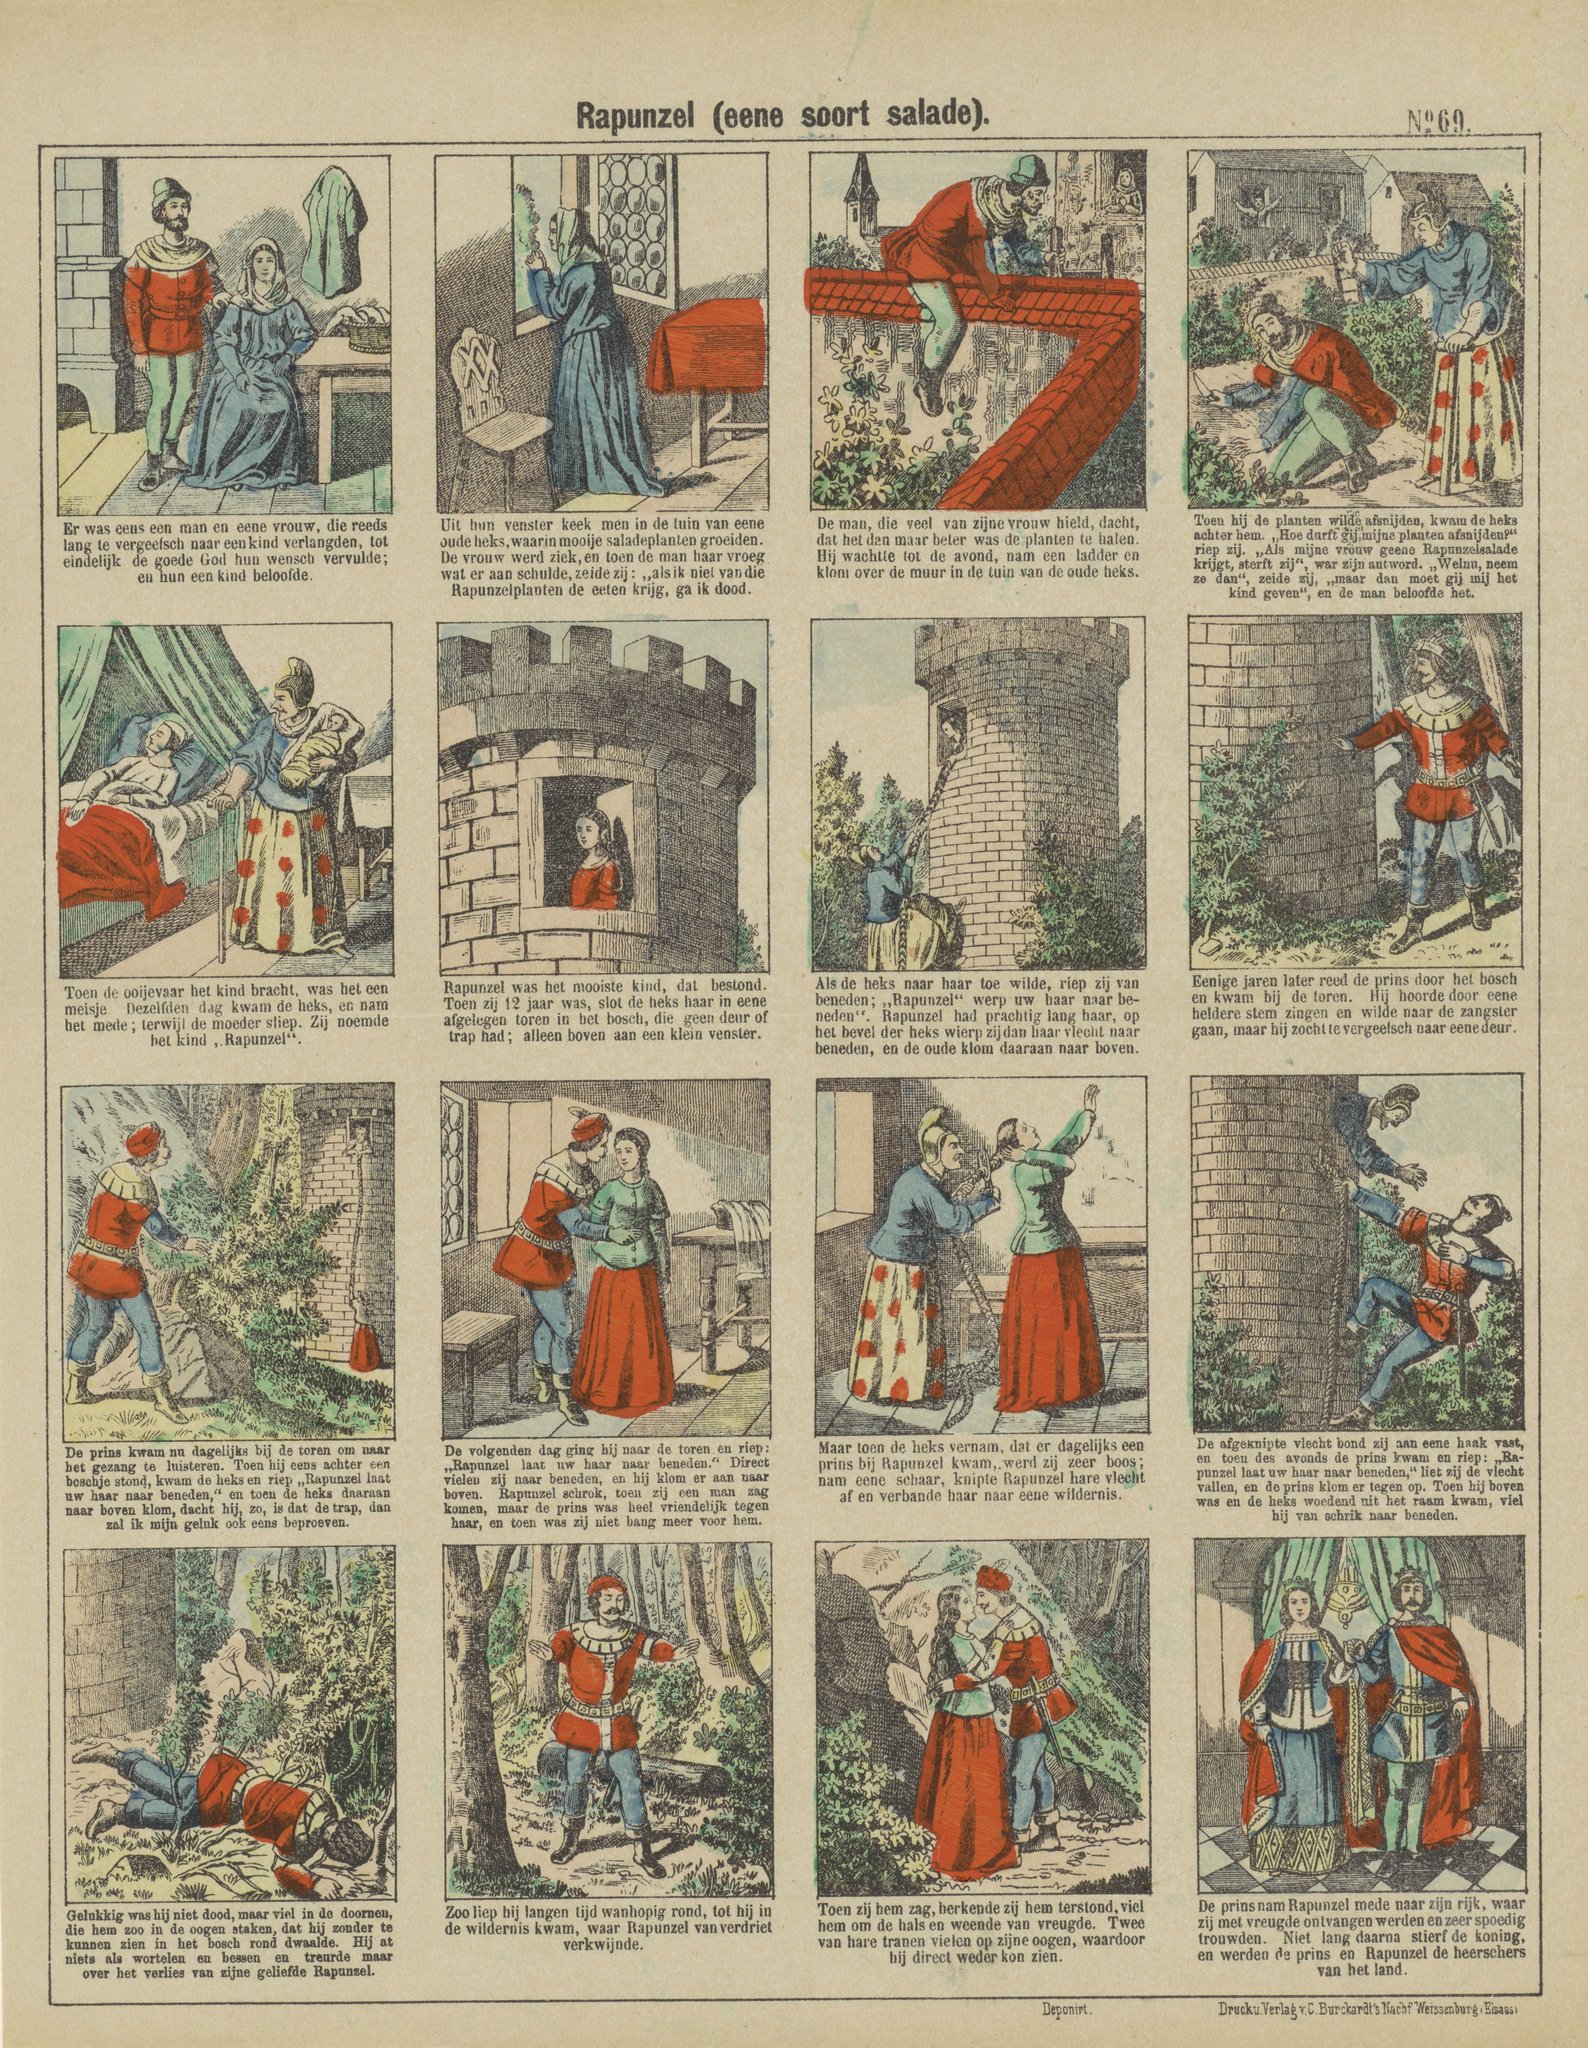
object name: print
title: Rapunzel (eene soort salade)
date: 1889-1906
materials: paper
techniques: hand coloring, letterpress printing, lithograph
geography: wissembourg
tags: tales and fairy tales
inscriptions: collector's mark: Lugt 2760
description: Blad met 16 voorstellingen uit het sprookje van Rapunzel. Onder elke afbeelding een onderschrift. Genummerd rechtsboven: No. 69.